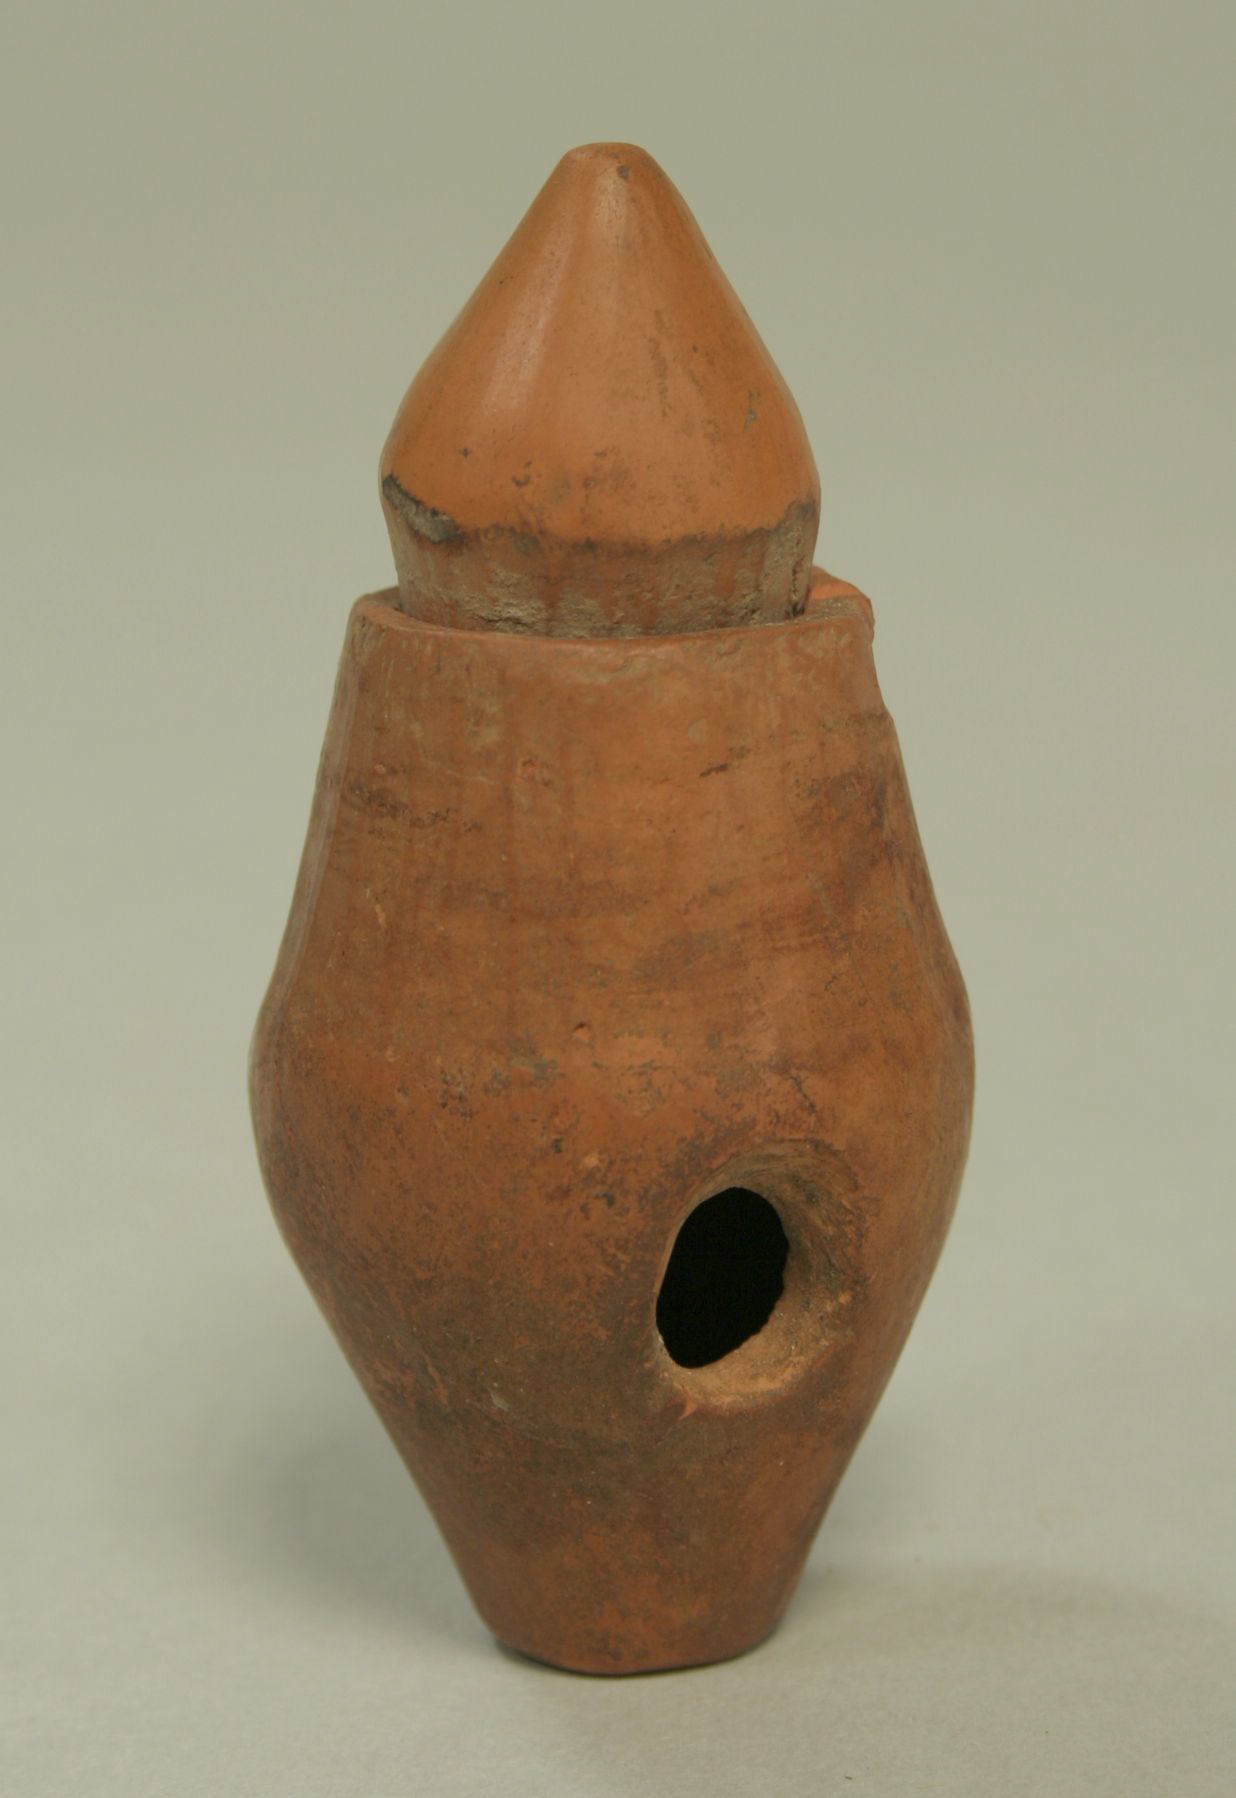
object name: whistle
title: Ceramic Whistle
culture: paracas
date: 300-1 BCE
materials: ceramic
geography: peru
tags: musical instruments